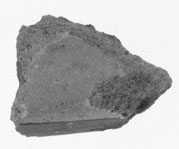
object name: shard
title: Shard (Study Collection)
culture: chinese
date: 1644-1911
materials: amber, ceramic, glaze